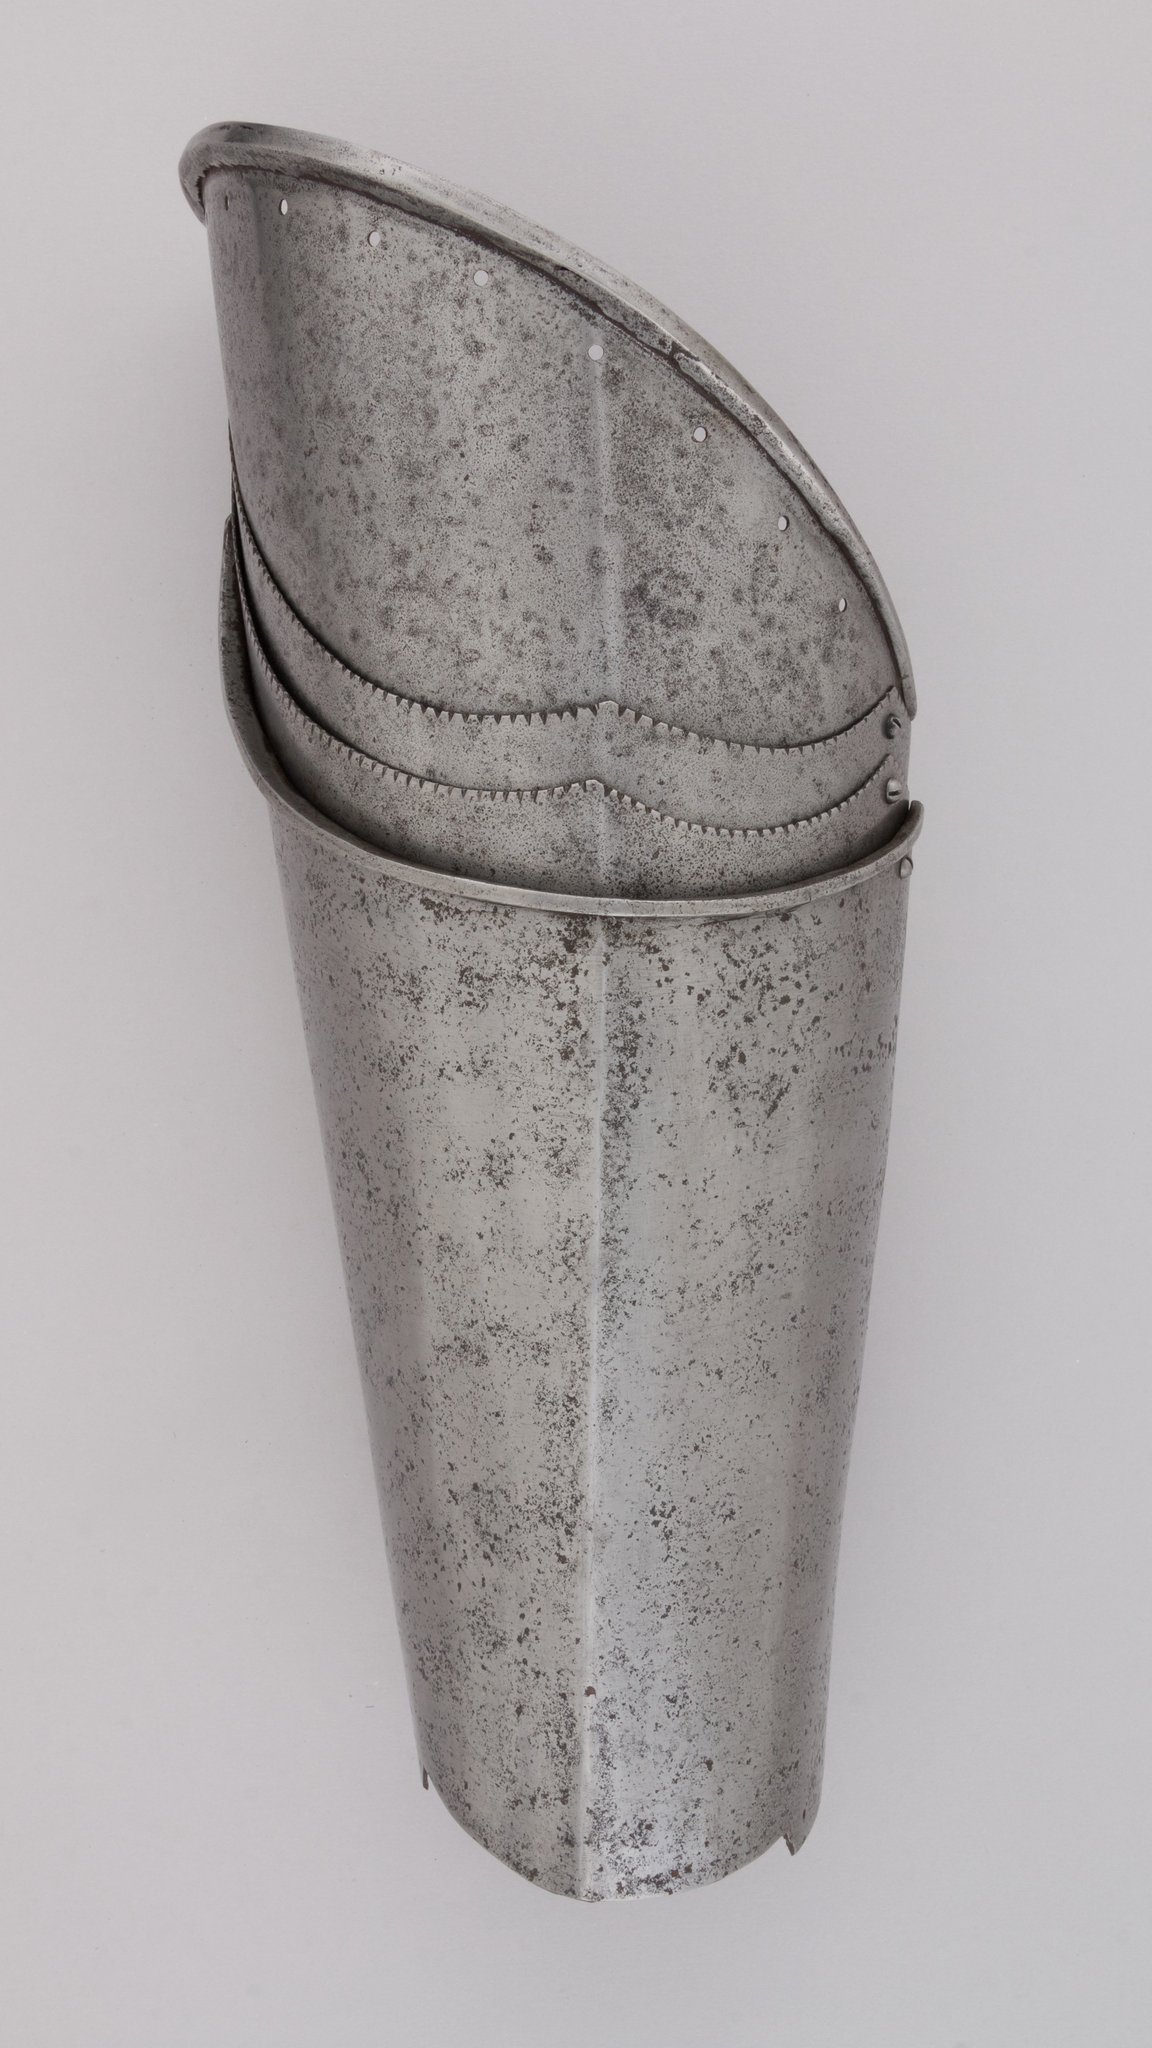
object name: pair of thigh defense cuisse with knee defense poleyns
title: Pair of Thigh Defenses (Cuisses)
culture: italian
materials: steel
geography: italy